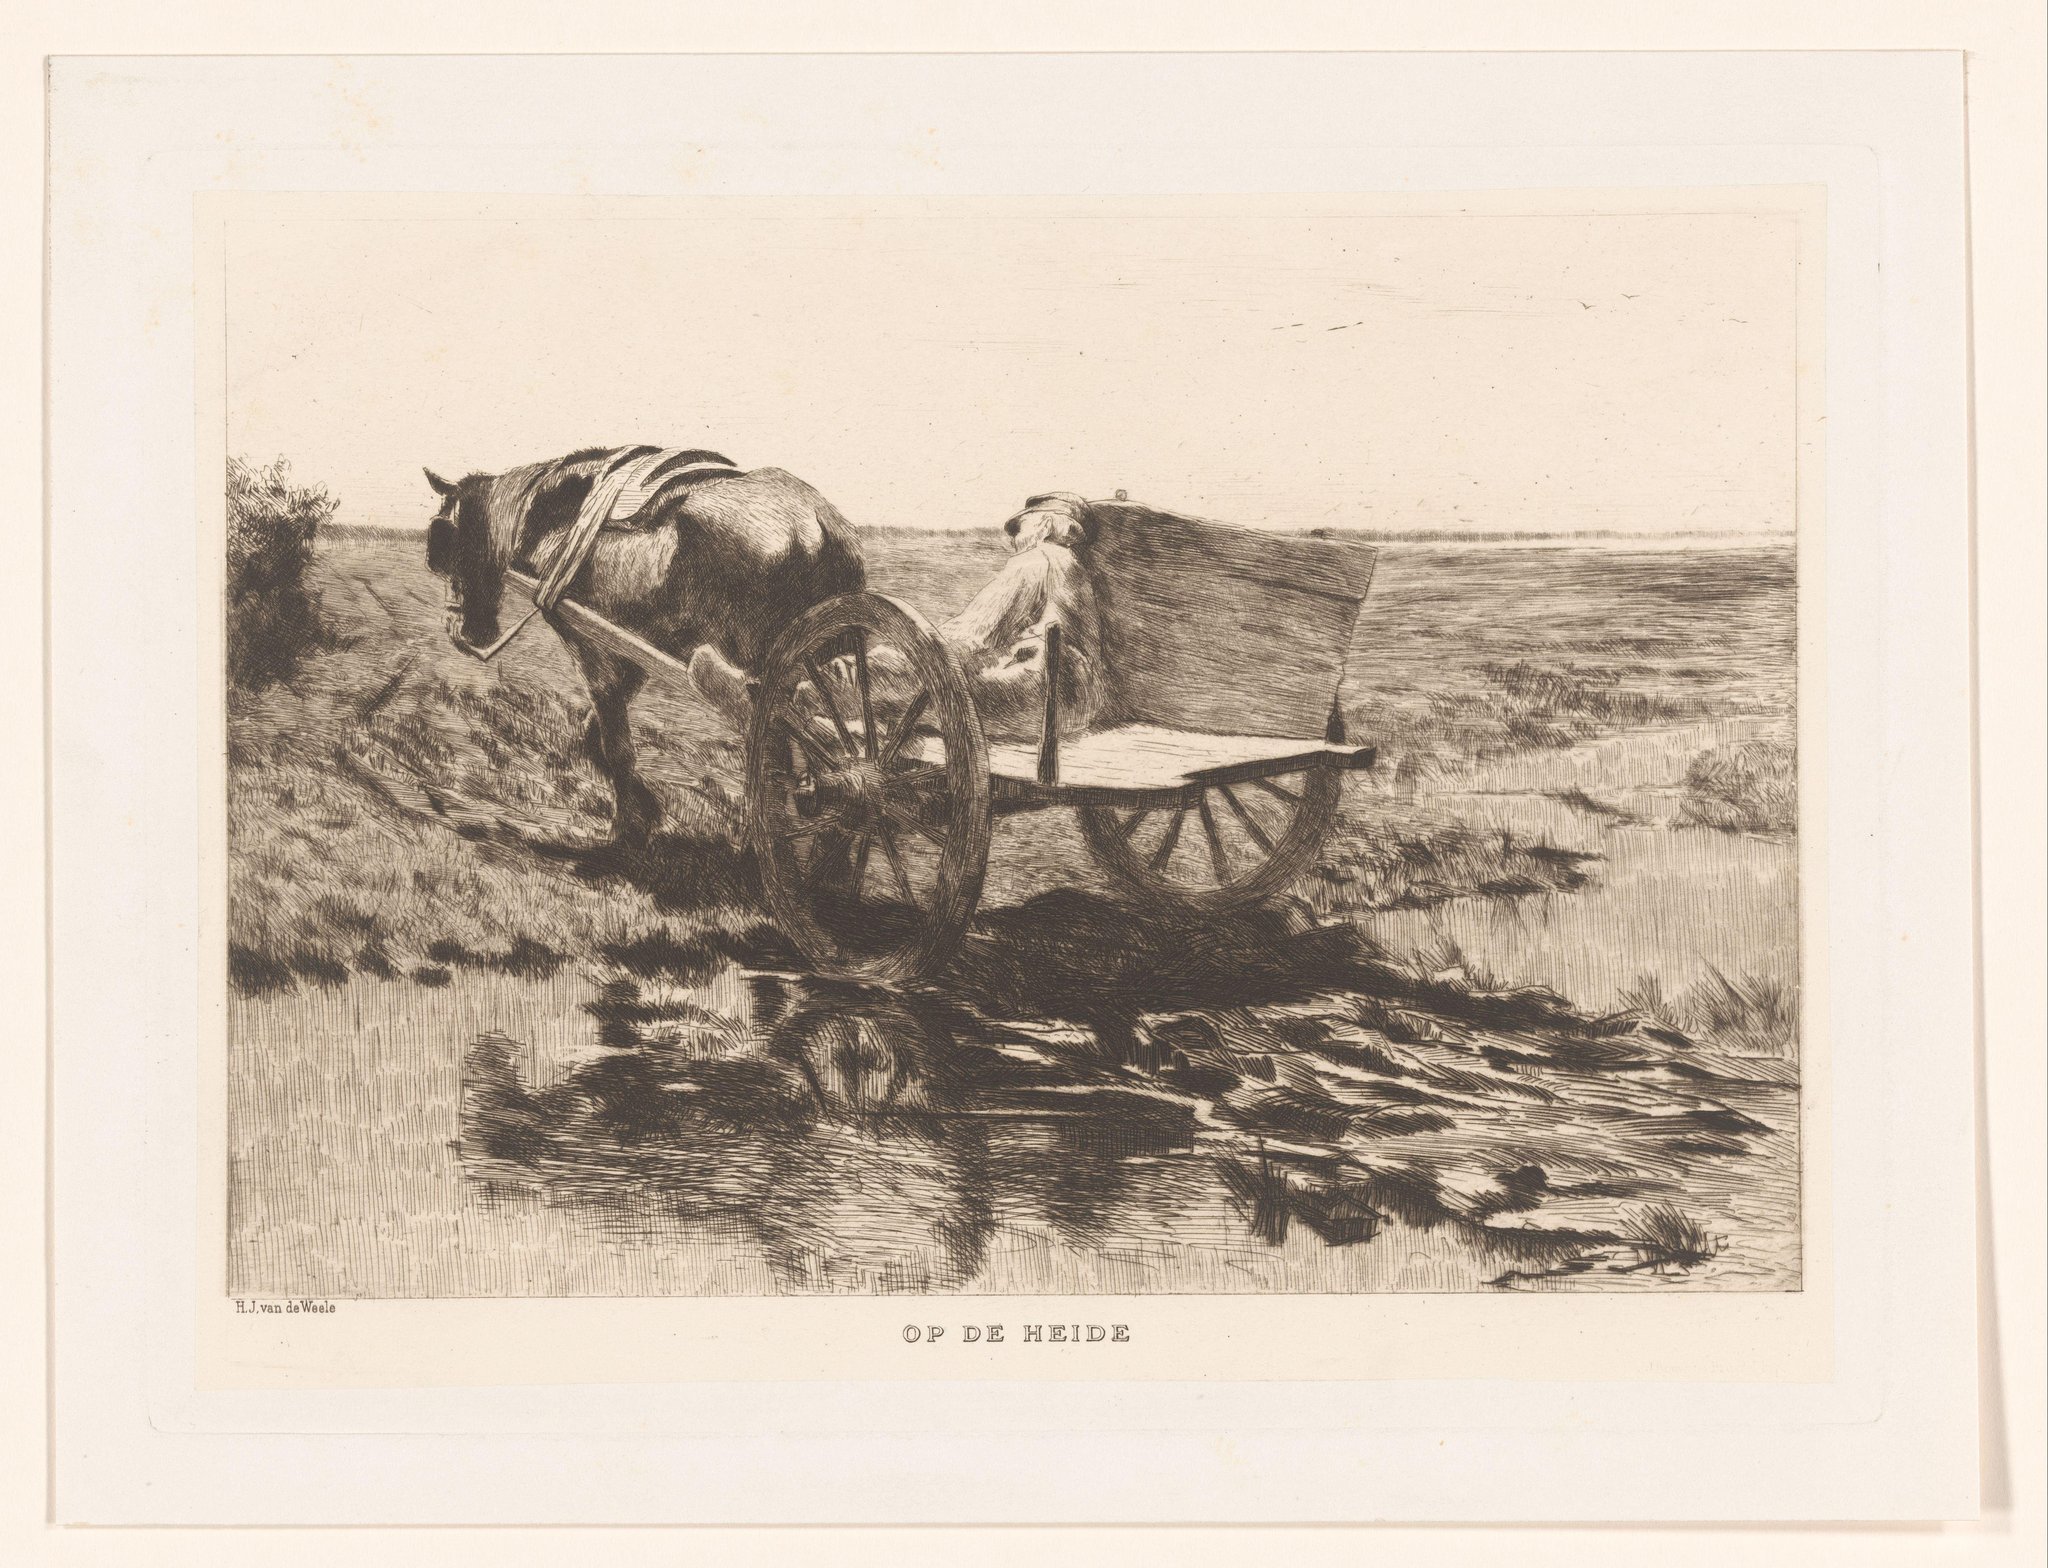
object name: print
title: Op de heide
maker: herman johannes van der weele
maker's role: print maker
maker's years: 1852-1930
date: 1862-1913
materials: paper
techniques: etching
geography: netherlands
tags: two-wheeled, animal-drawn vehicle, farmers, horse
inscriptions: collector's mark: Lugt 2228